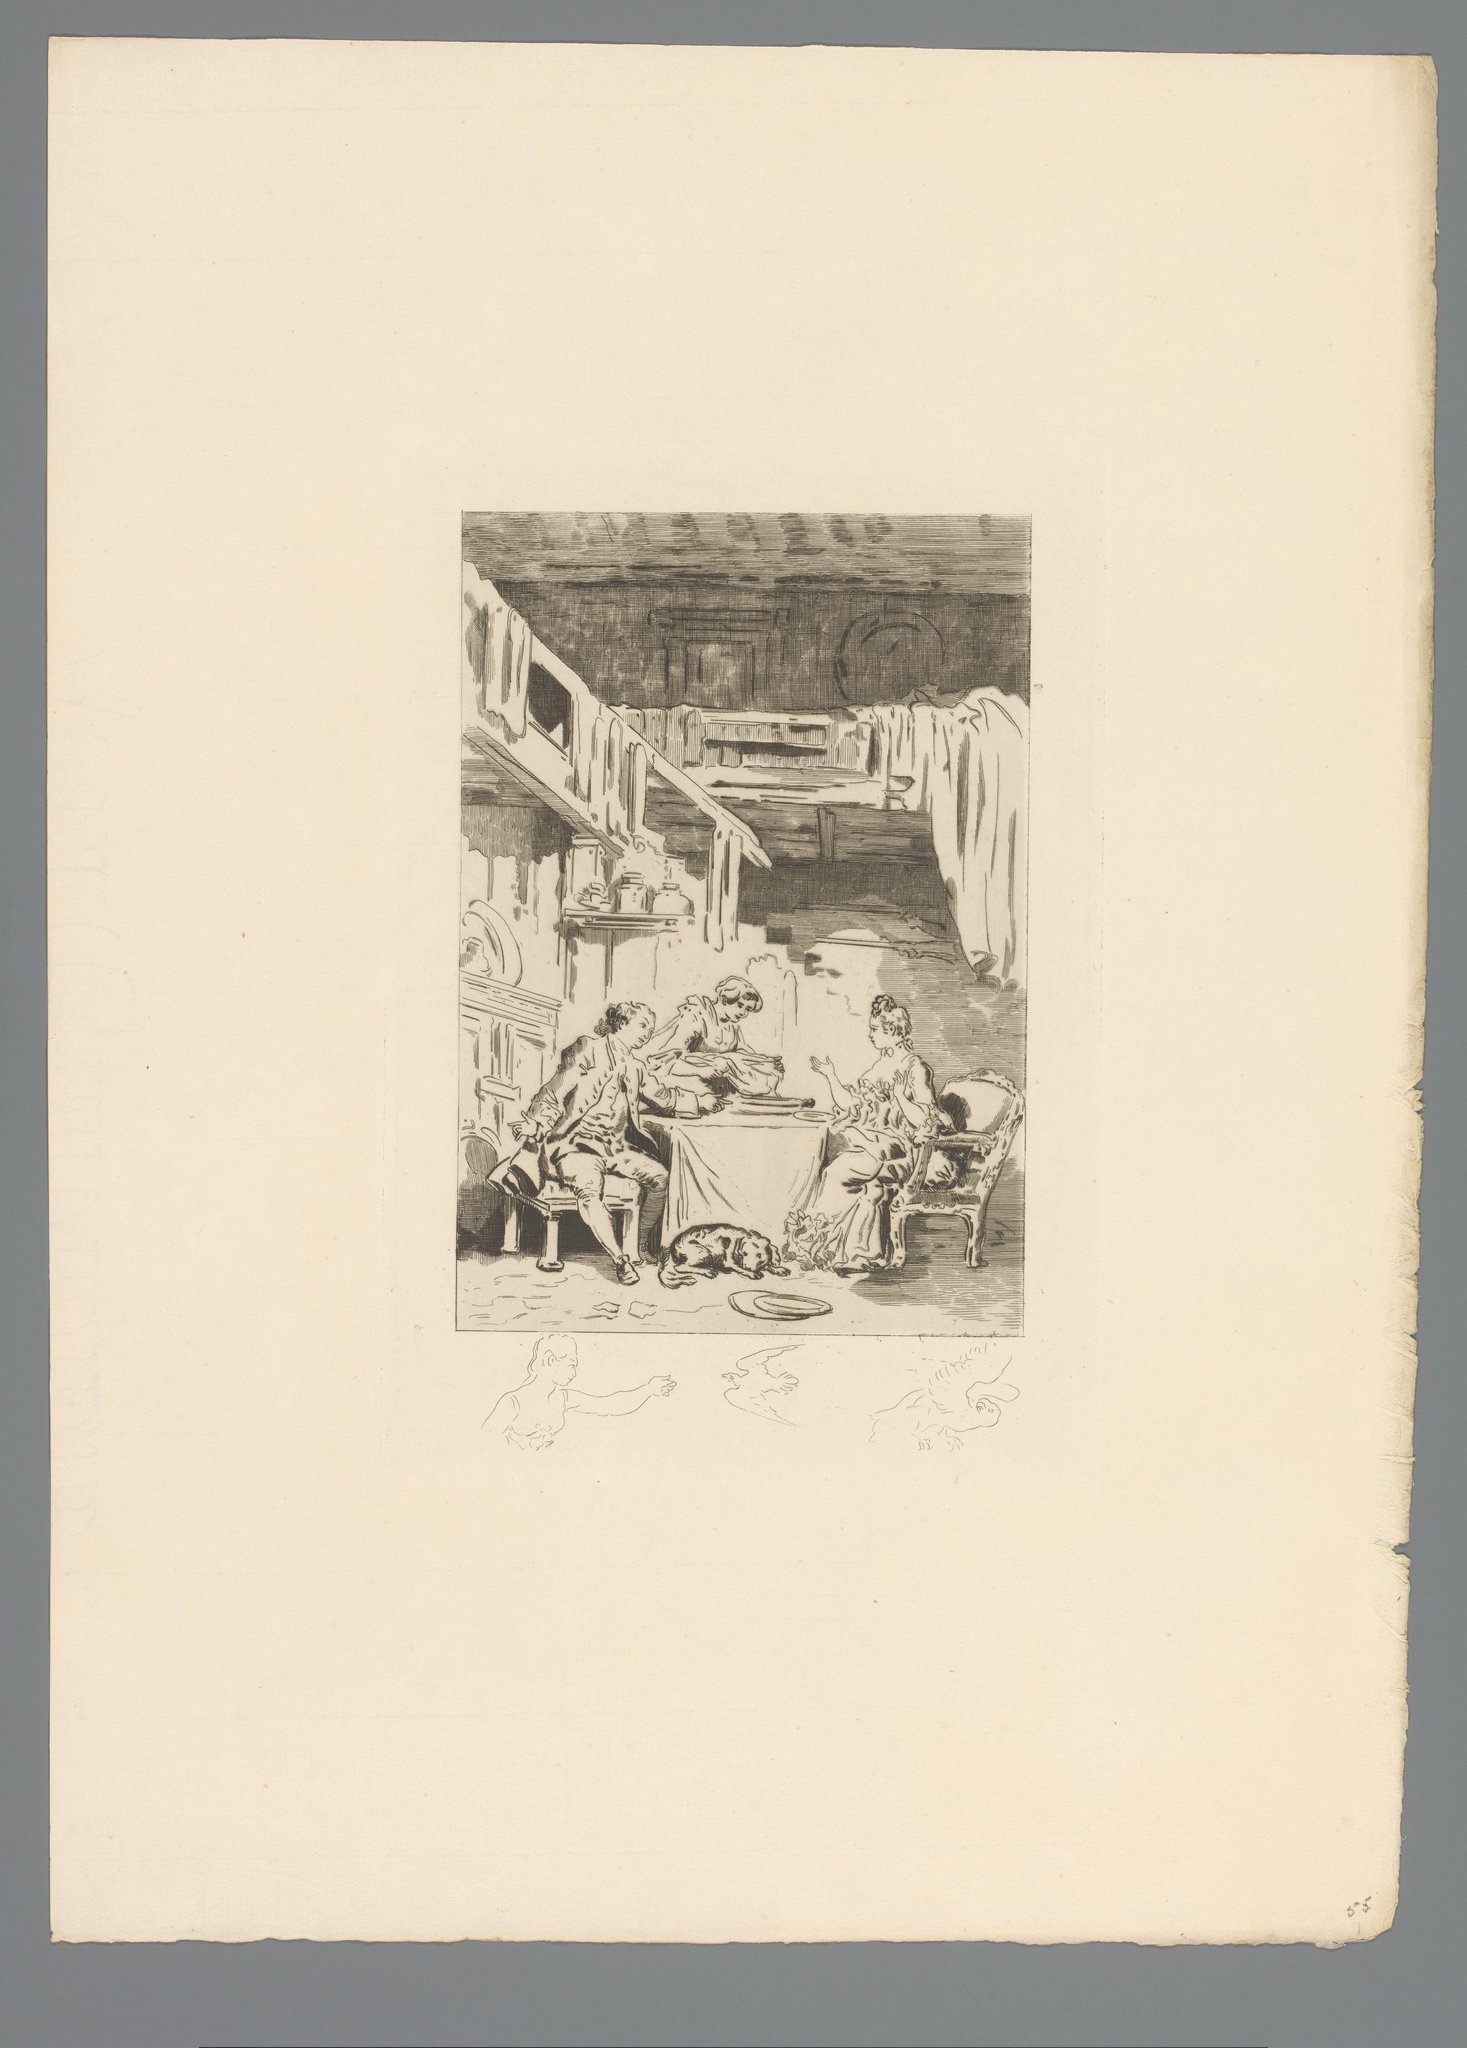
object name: reproduction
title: Figuren uit de verhalen van La Fontaine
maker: Anonymous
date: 1880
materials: paper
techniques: photoaquatint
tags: predatory birds: falcon, house personnel, servants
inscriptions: collector's mark:, collector's mark: Lugt 2228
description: Martial Potémont maakte etsen naar de tekeningen van Fragonard, die zich bevonden in een manuscript in de collectie van de verzamelaar Eugène Paillet. Rouquette bood hem aan de tekeningen zo exact mogelijk in prent te laten brengen door Martial Potémont: dit resulteerde in een serie van 57 etsen. Vervolgens werden deze gereproduceerd door middel van heliogravure. Deze omslag betreft een editie voor de letter, "Eau forte pure", de 1e staat van 3 waar men uit kon kiezen bij deze serie.